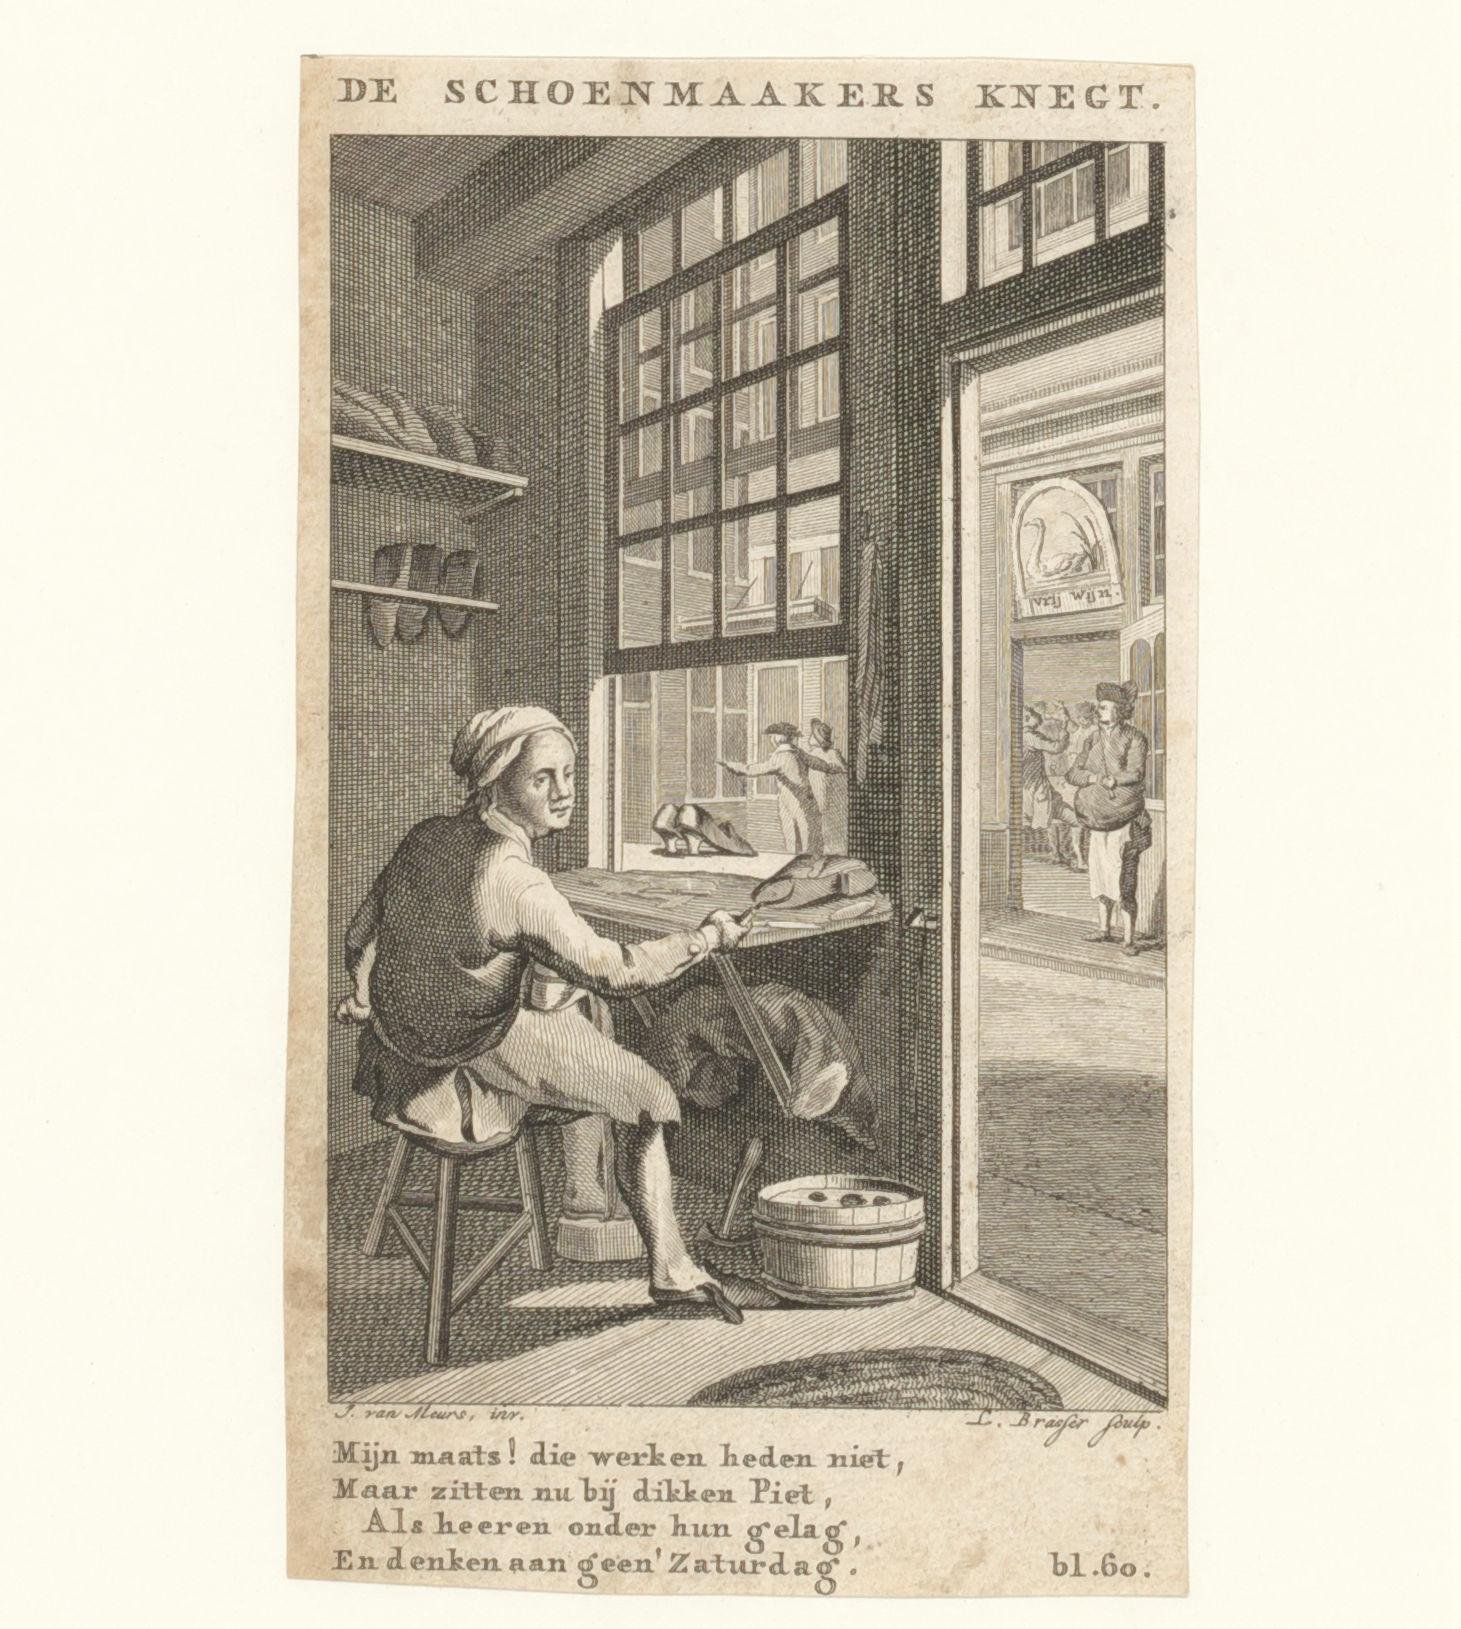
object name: print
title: De schoenmaakers knegt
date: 1789-1791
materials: paper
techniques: engraving, etching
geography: netherlands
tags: inn, coffee-house, public house, etc., shoe-maker, cobbler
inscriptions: collector's mark: Lugt 1641, collector's mark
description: Gebruikt als illustratie in: Volks-liedjes, uitgegeven door de Maatschappij tot Nut van 't Algemeen, Amsterdam: Harmanus Keijzer, Arend Fokke en Cornelis de Vries, 3 delen, 1789-1791, p. 58/59.